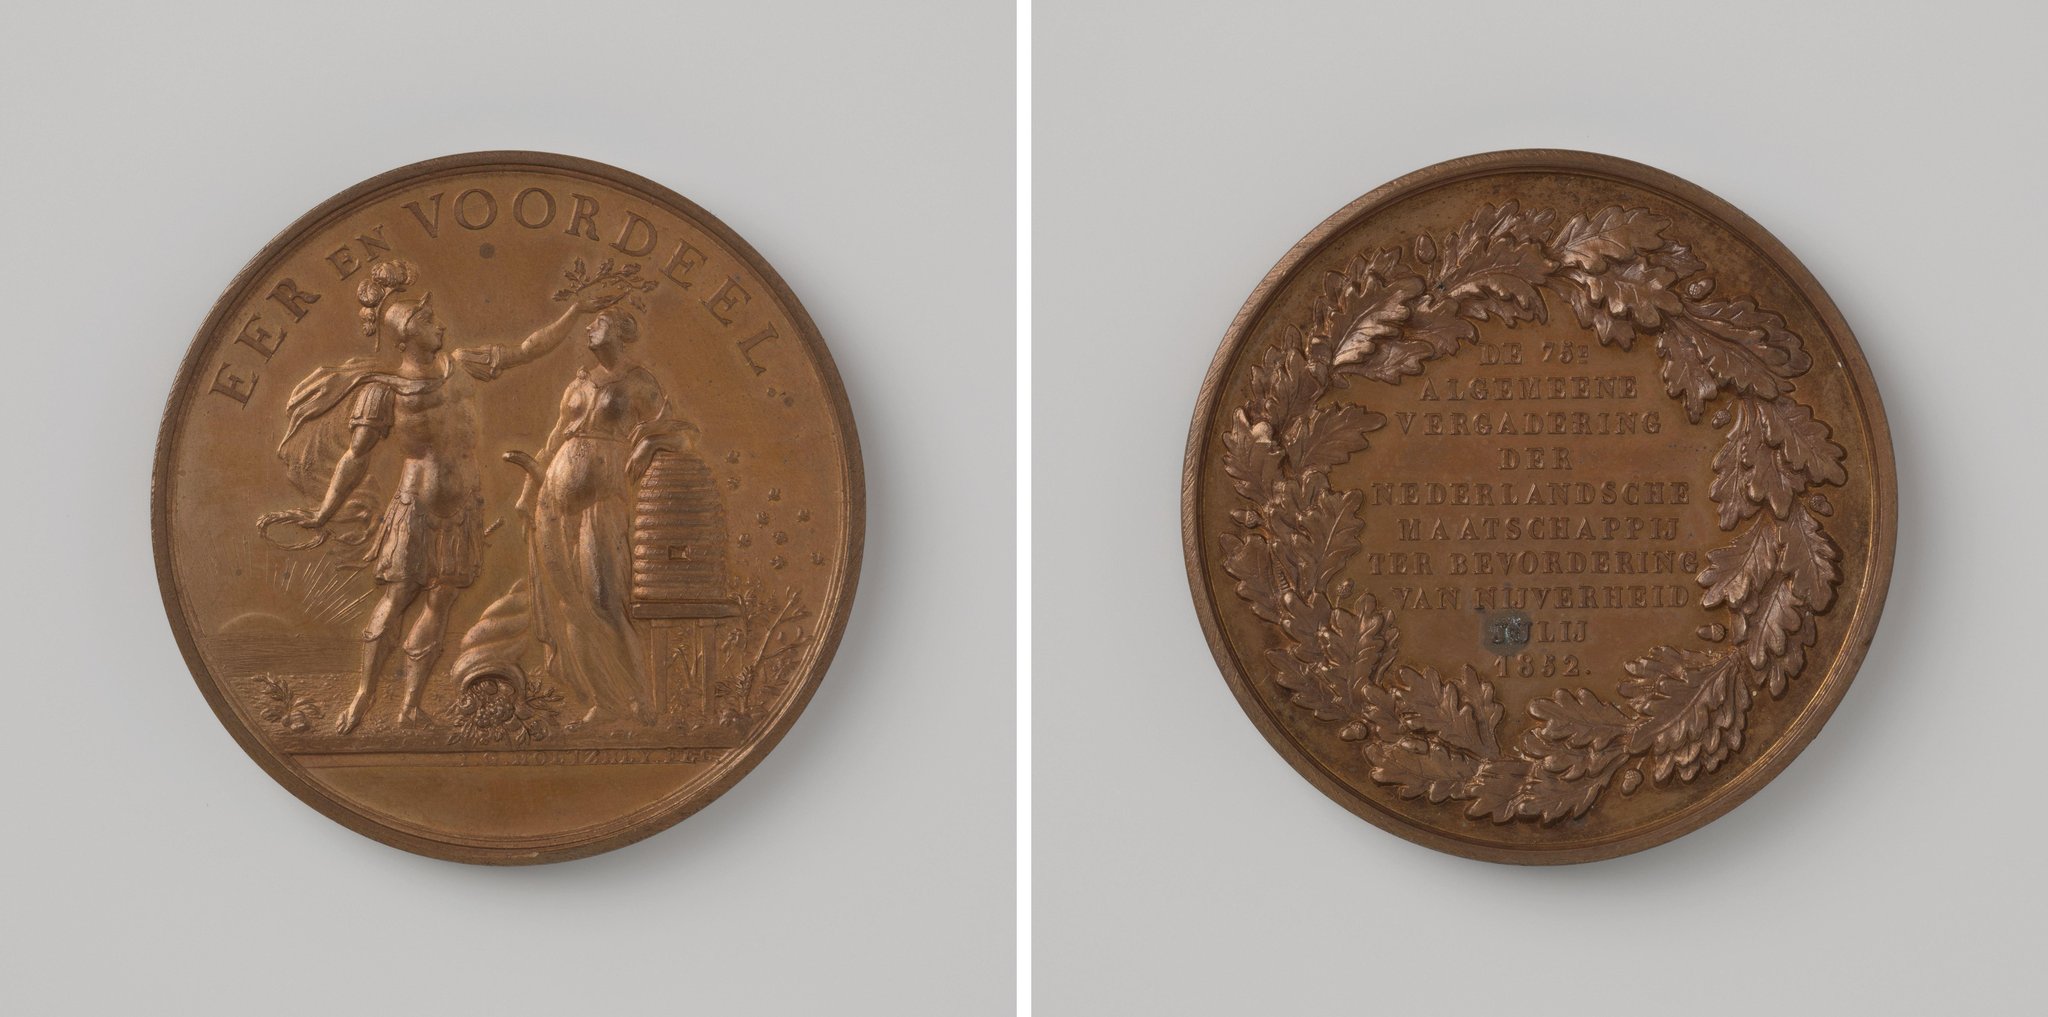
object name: history medal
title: Vijfenzeventigste vergadering van de Nederlandsche Maatschappij ter Bevordering van Nijverheid 1852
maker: david van der kellen (1804-1879)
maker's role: die cutter, draughtsman, print maker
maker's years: 1804-1879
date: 1852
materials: bronze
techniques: striking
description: Bronzen penning, op de voorzijde de Vaderlandsliefde als vrouw in militair tenue lauwert de Nijverheid, met hoorn des overvloeds leunend op een bijenkorf, met omschrift, op de keerzijde tien regels tekst binnen een zware eikenkrans.